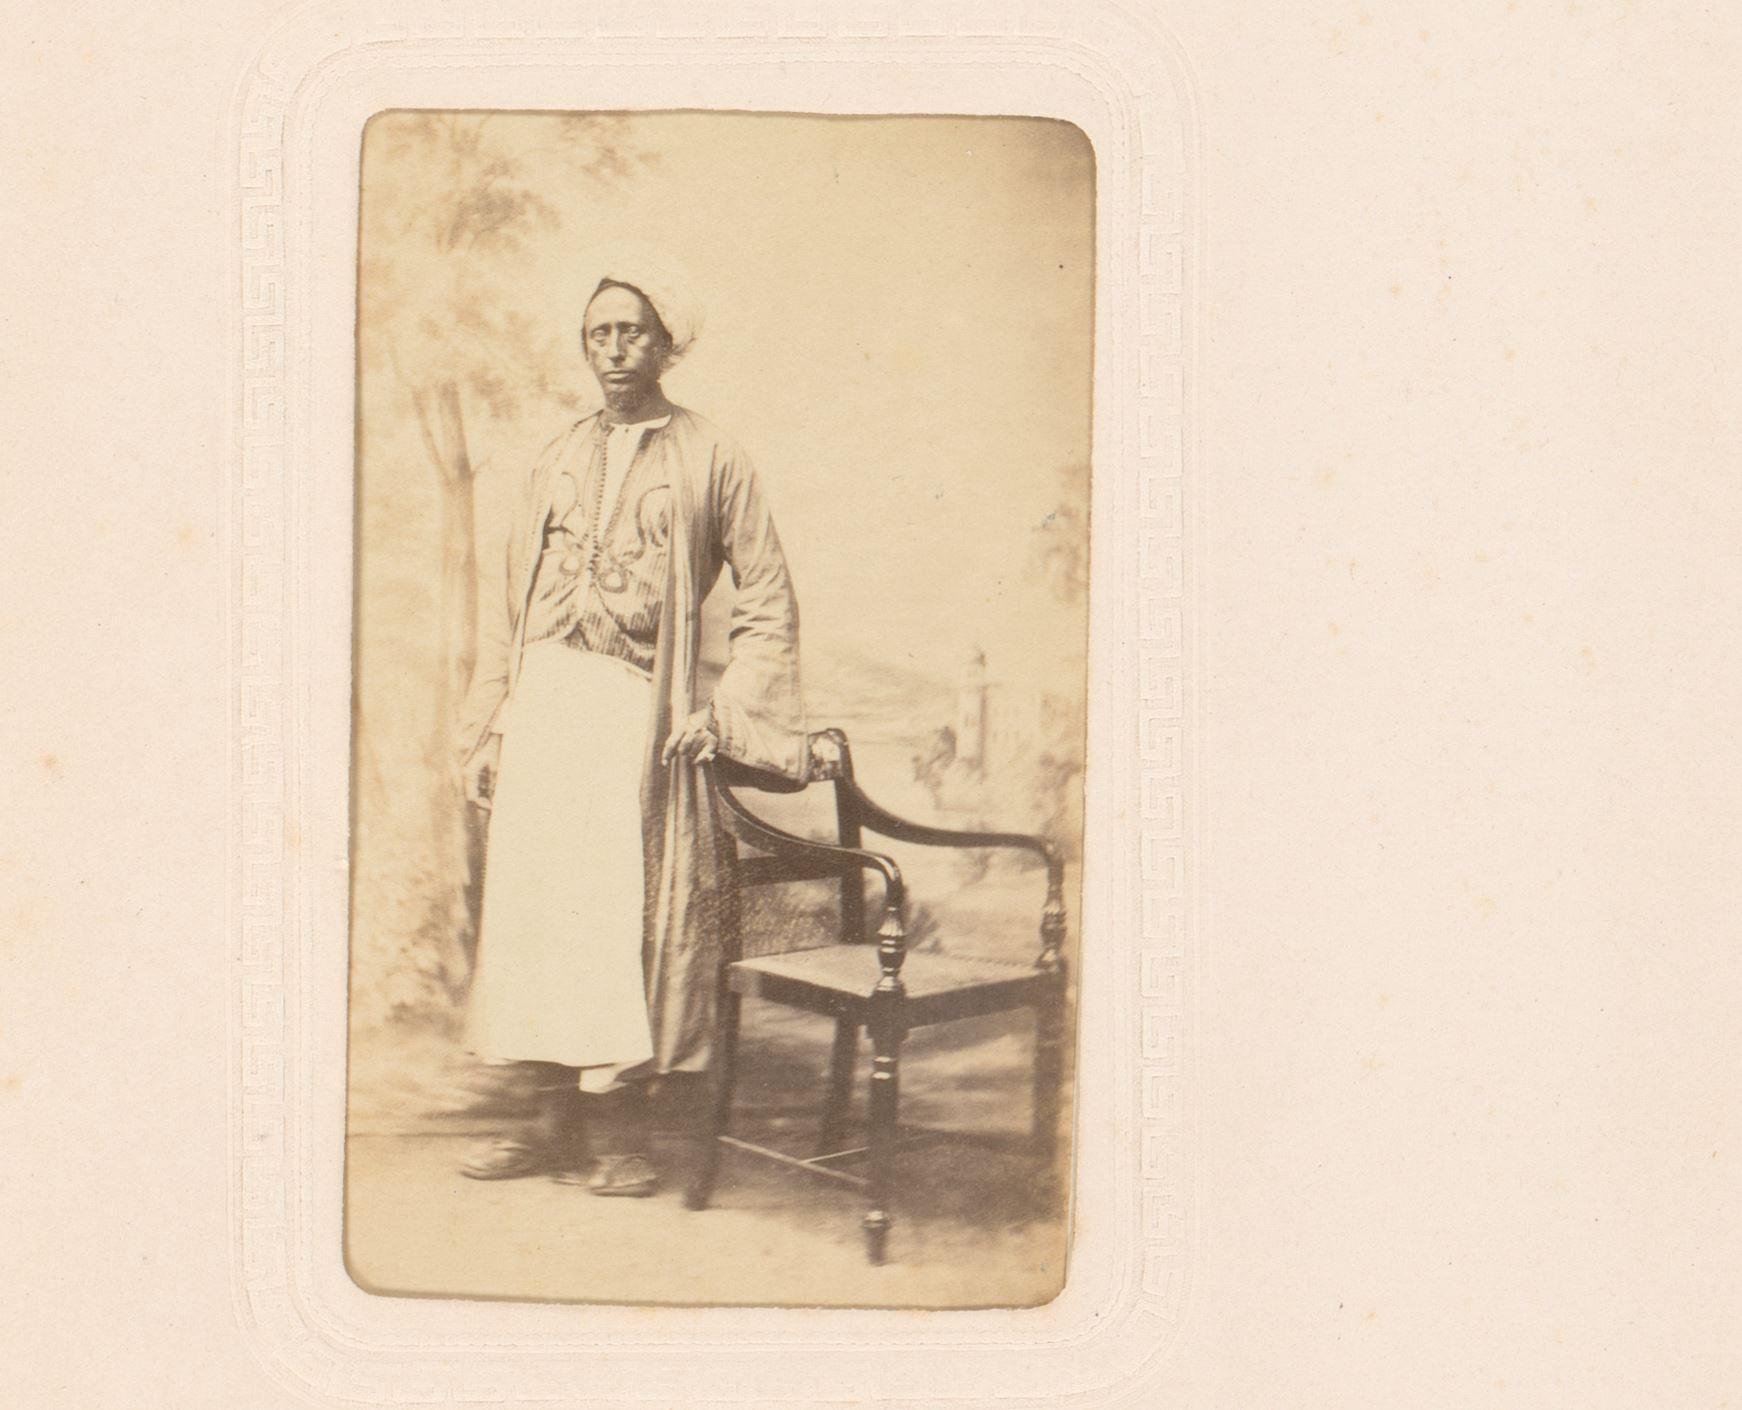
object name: photograph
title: Portret van een Indiase man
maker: Anonymous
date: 1850-1880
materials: paper, photographic support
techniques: albumen print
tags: historical persons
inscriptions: number: ‘31’